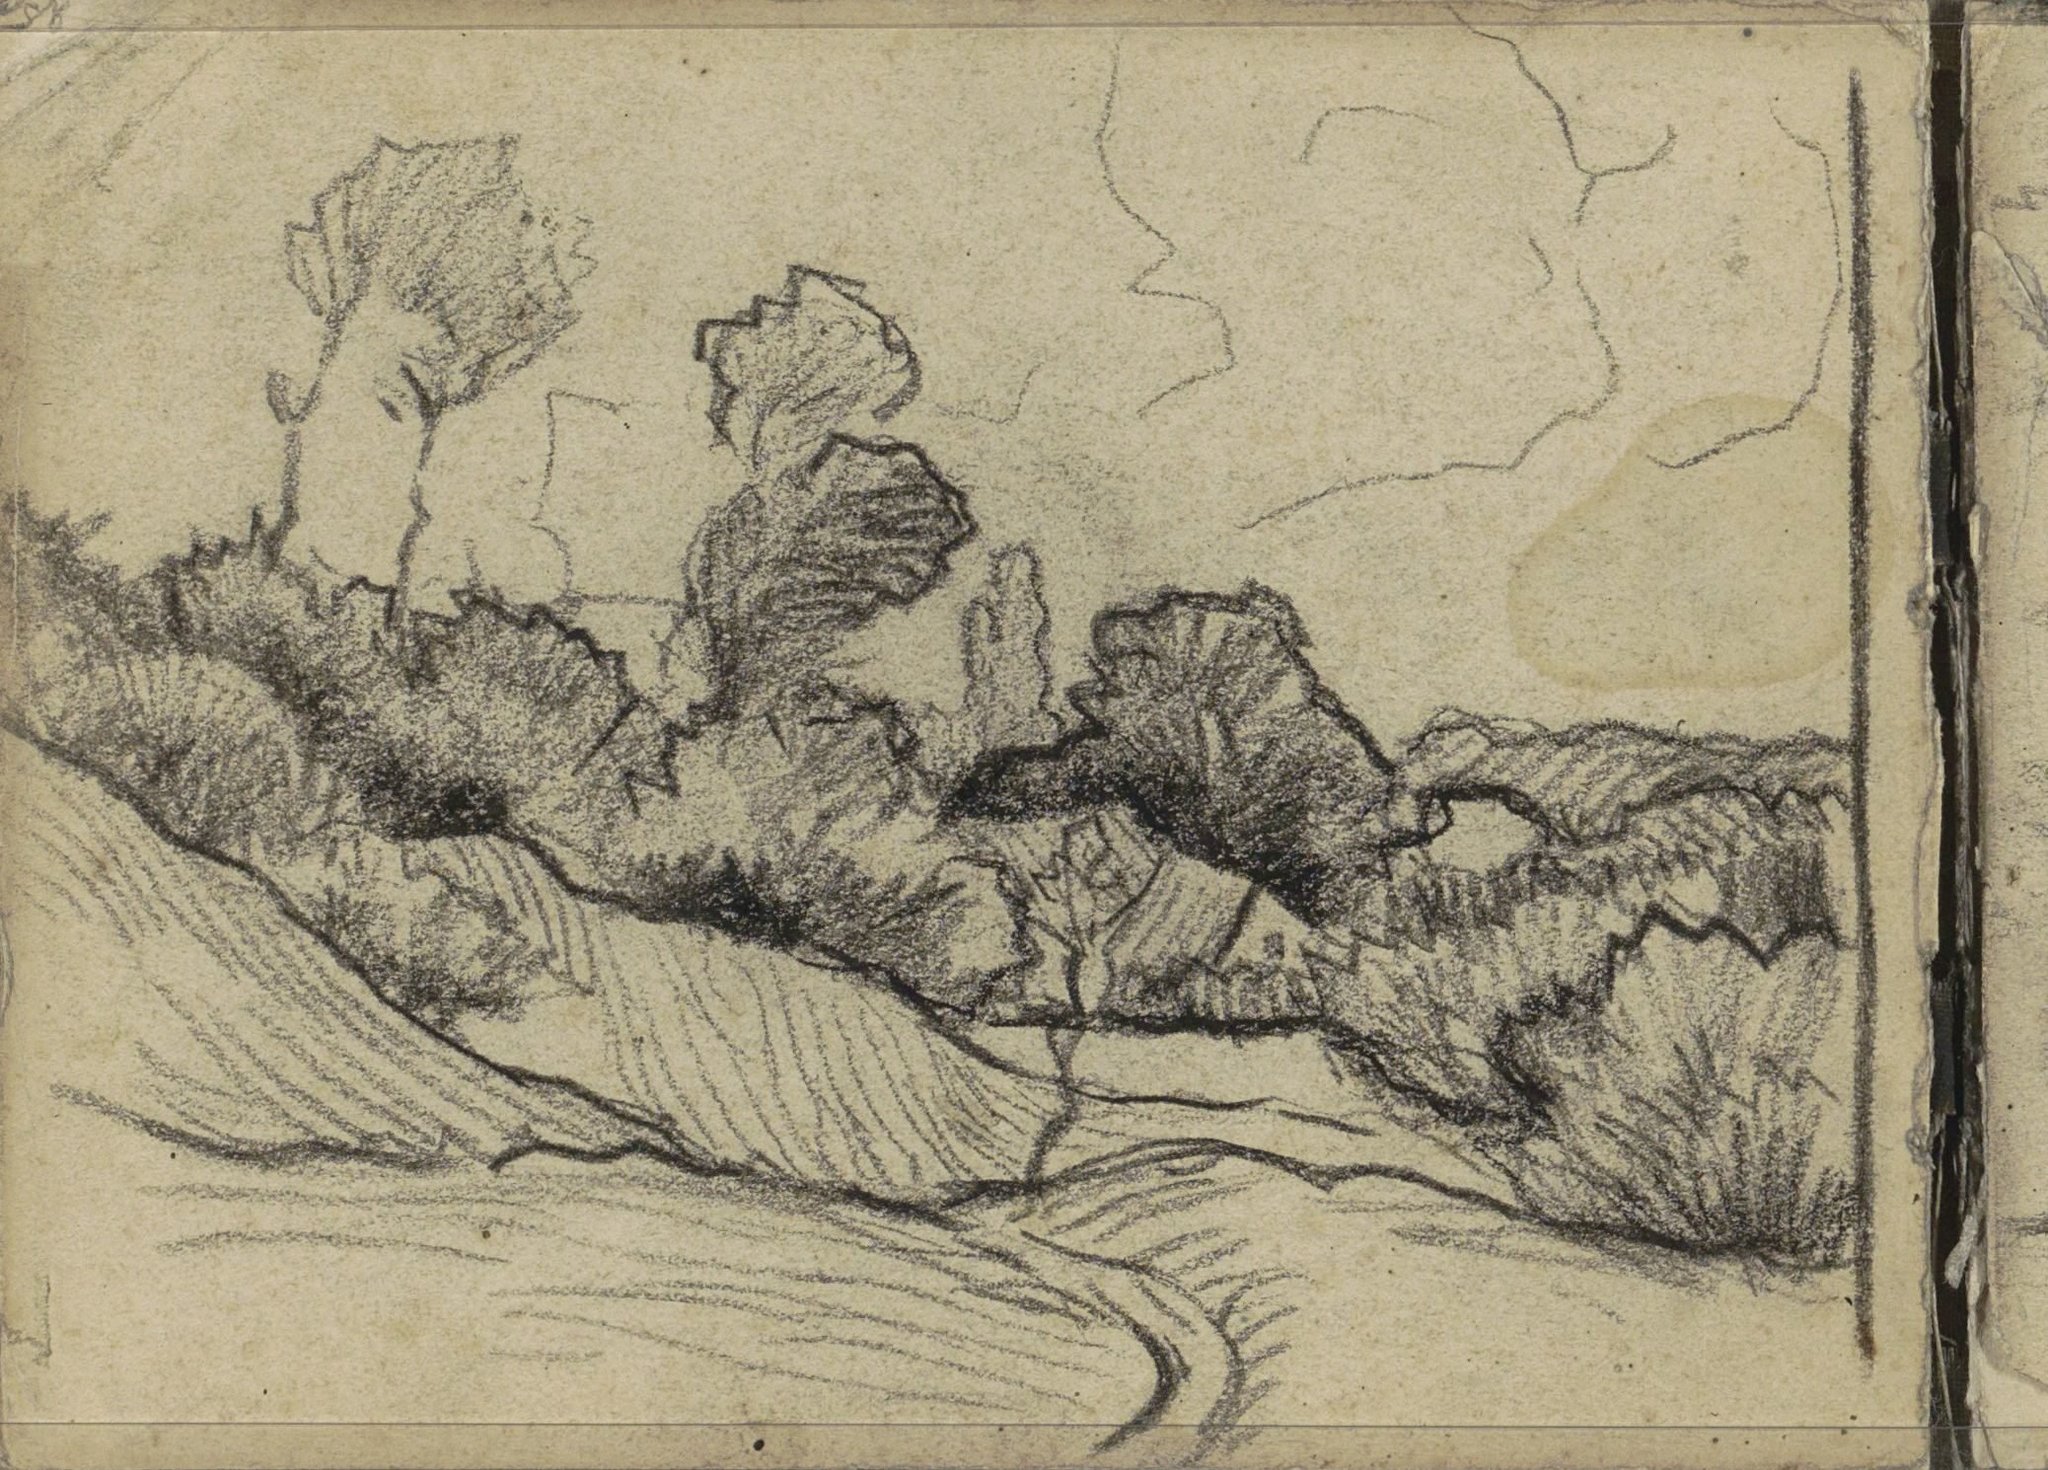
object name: sketchbook leaf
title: Heuvellandschap met huizen in een dal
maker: hermannus adrianus van oosterzee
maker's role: draughtsman, painter, print maker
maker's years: 1863-1933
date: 1893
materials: chalk, paper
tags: dale, valley, city-view, and landscape with man-made constructions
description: Blad 22 verso uit een schetsboek met 23 bladen.